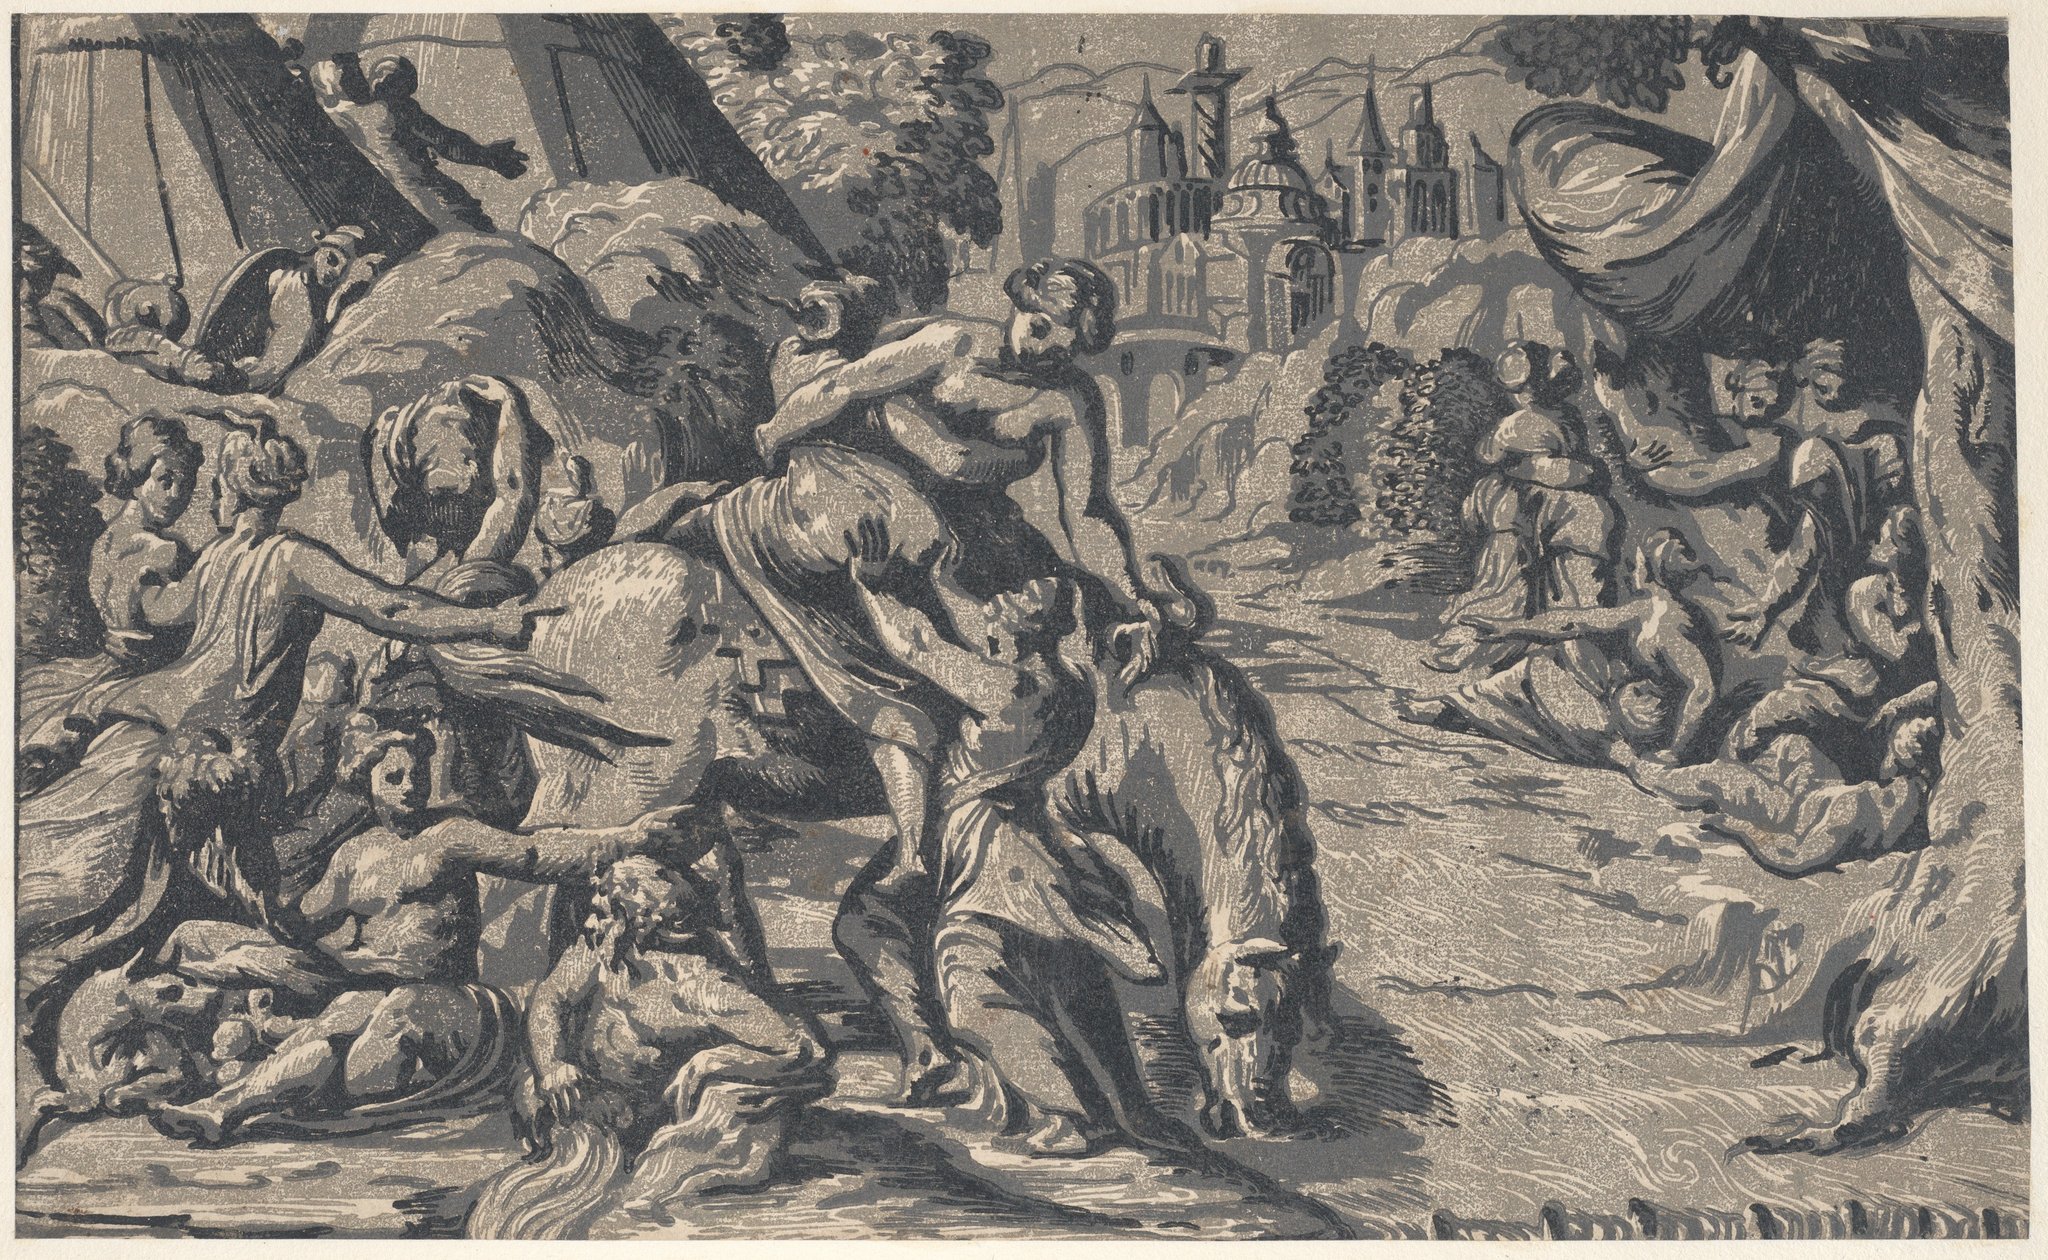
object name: print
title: The escape of Cloelia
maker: niccolò vicentino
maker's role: artist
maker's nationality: italian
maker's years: 1510-1550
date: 1540-1550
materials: ink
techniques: woodcut